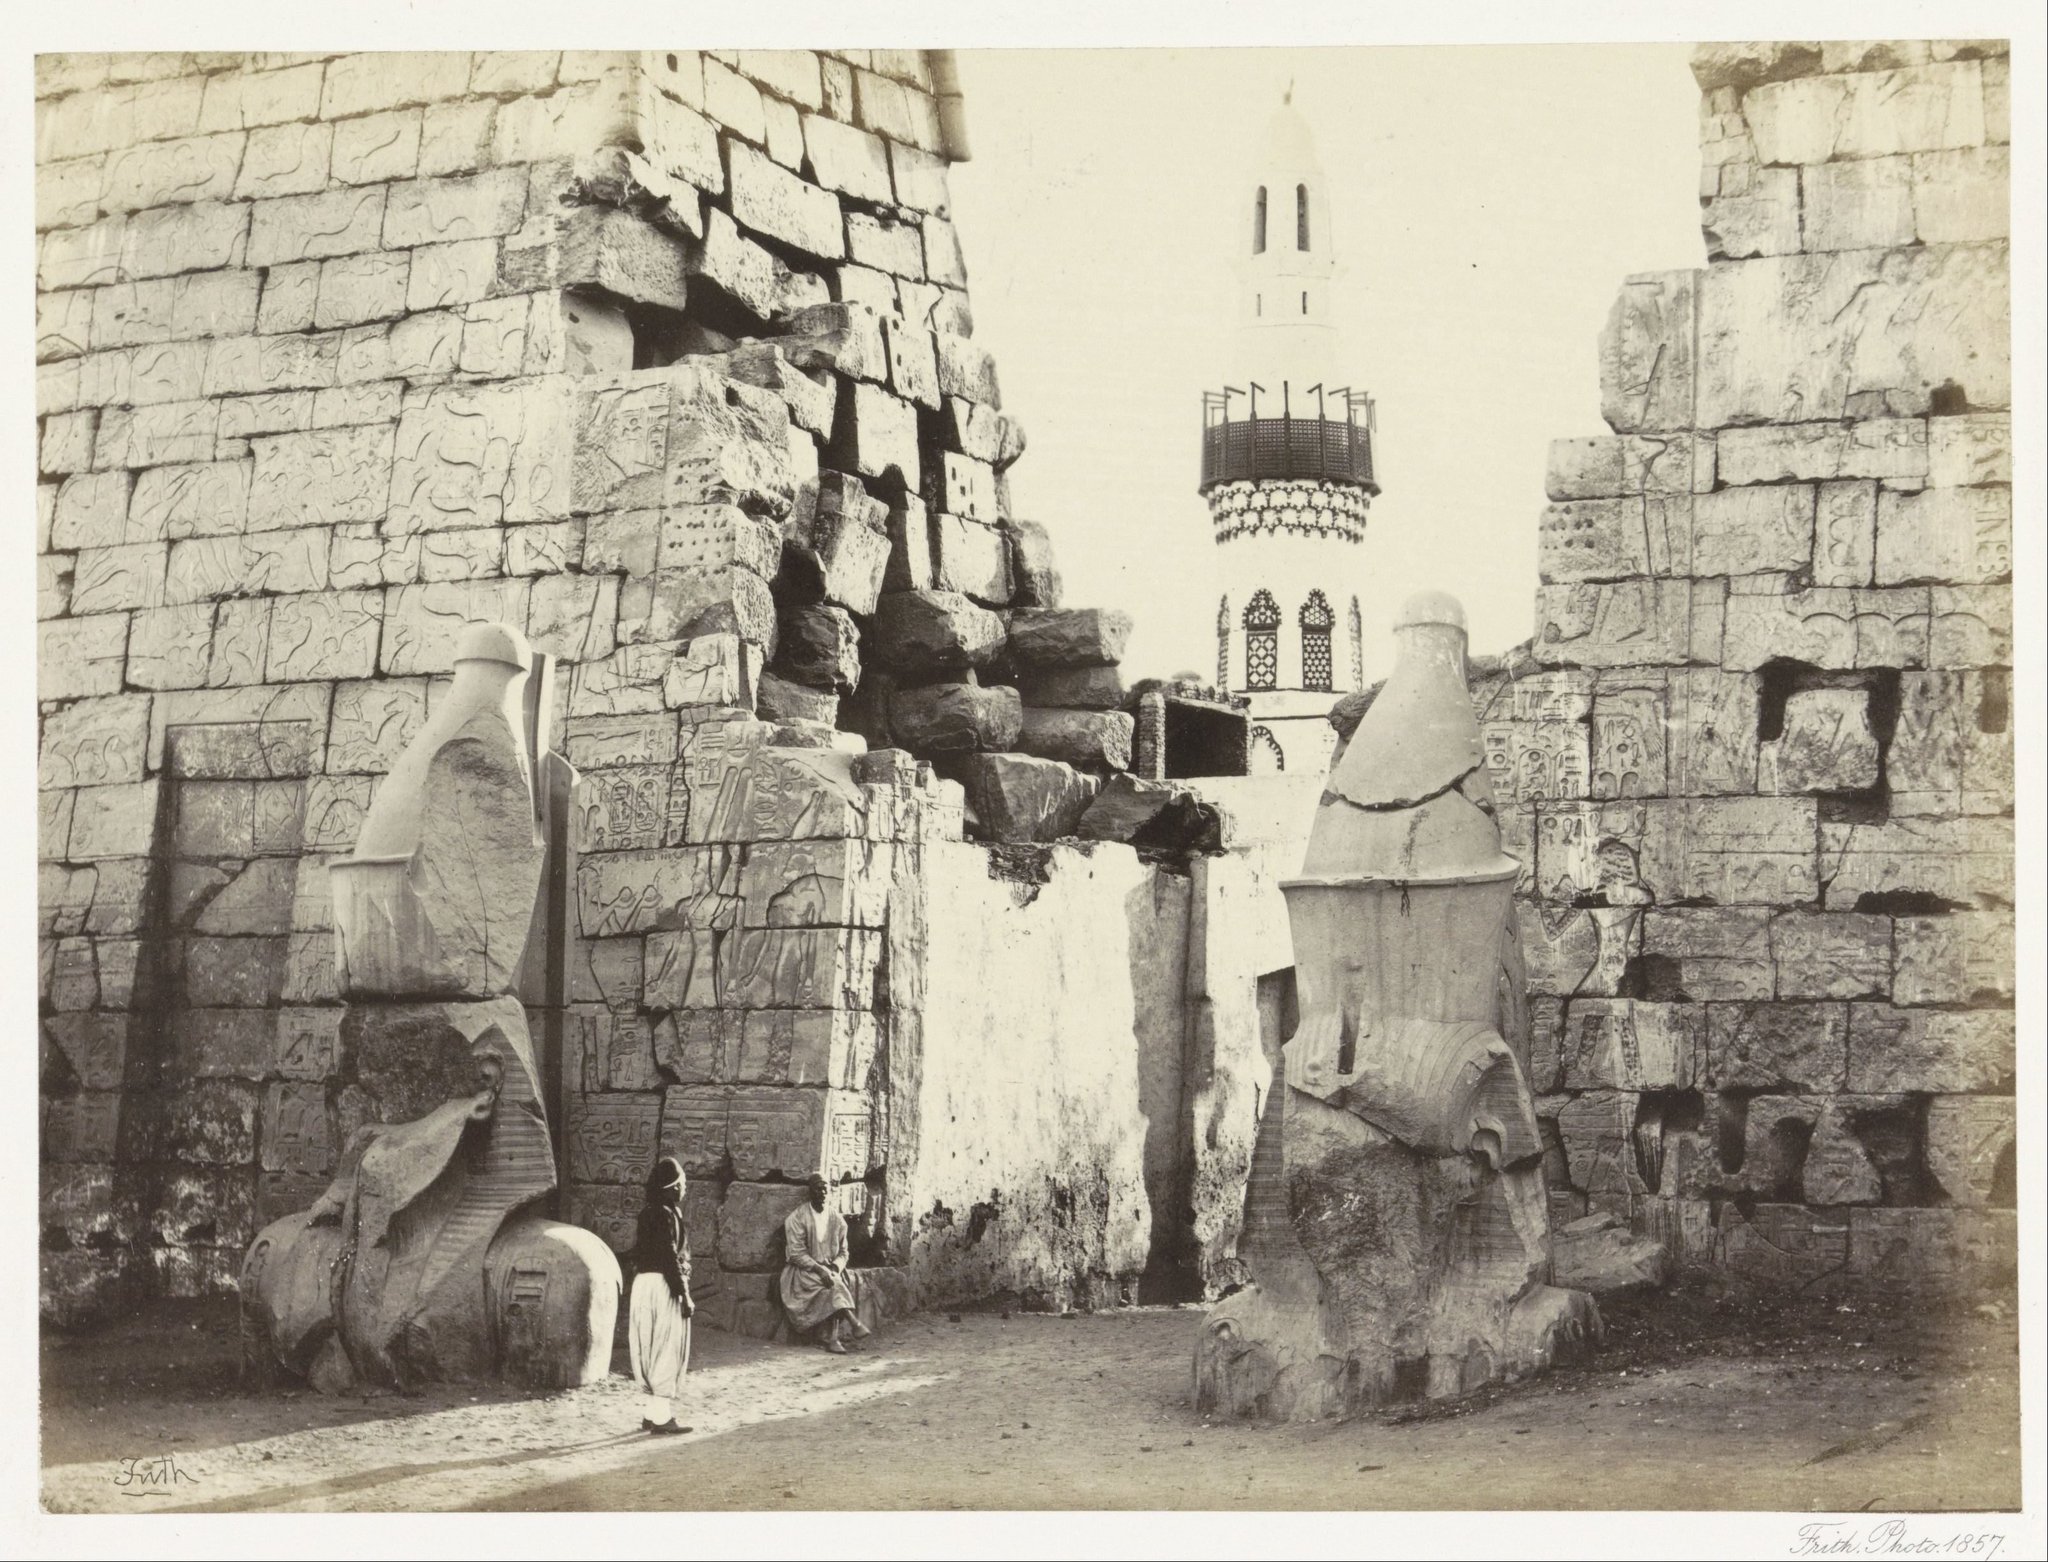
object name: page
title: Ingang naar de Luxortempel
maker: francis frith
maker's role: publisher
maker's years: 1822-1898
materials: paper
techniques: albumen print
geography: luxor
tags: temple, shrine ~ egyptian religion, gate, entrance